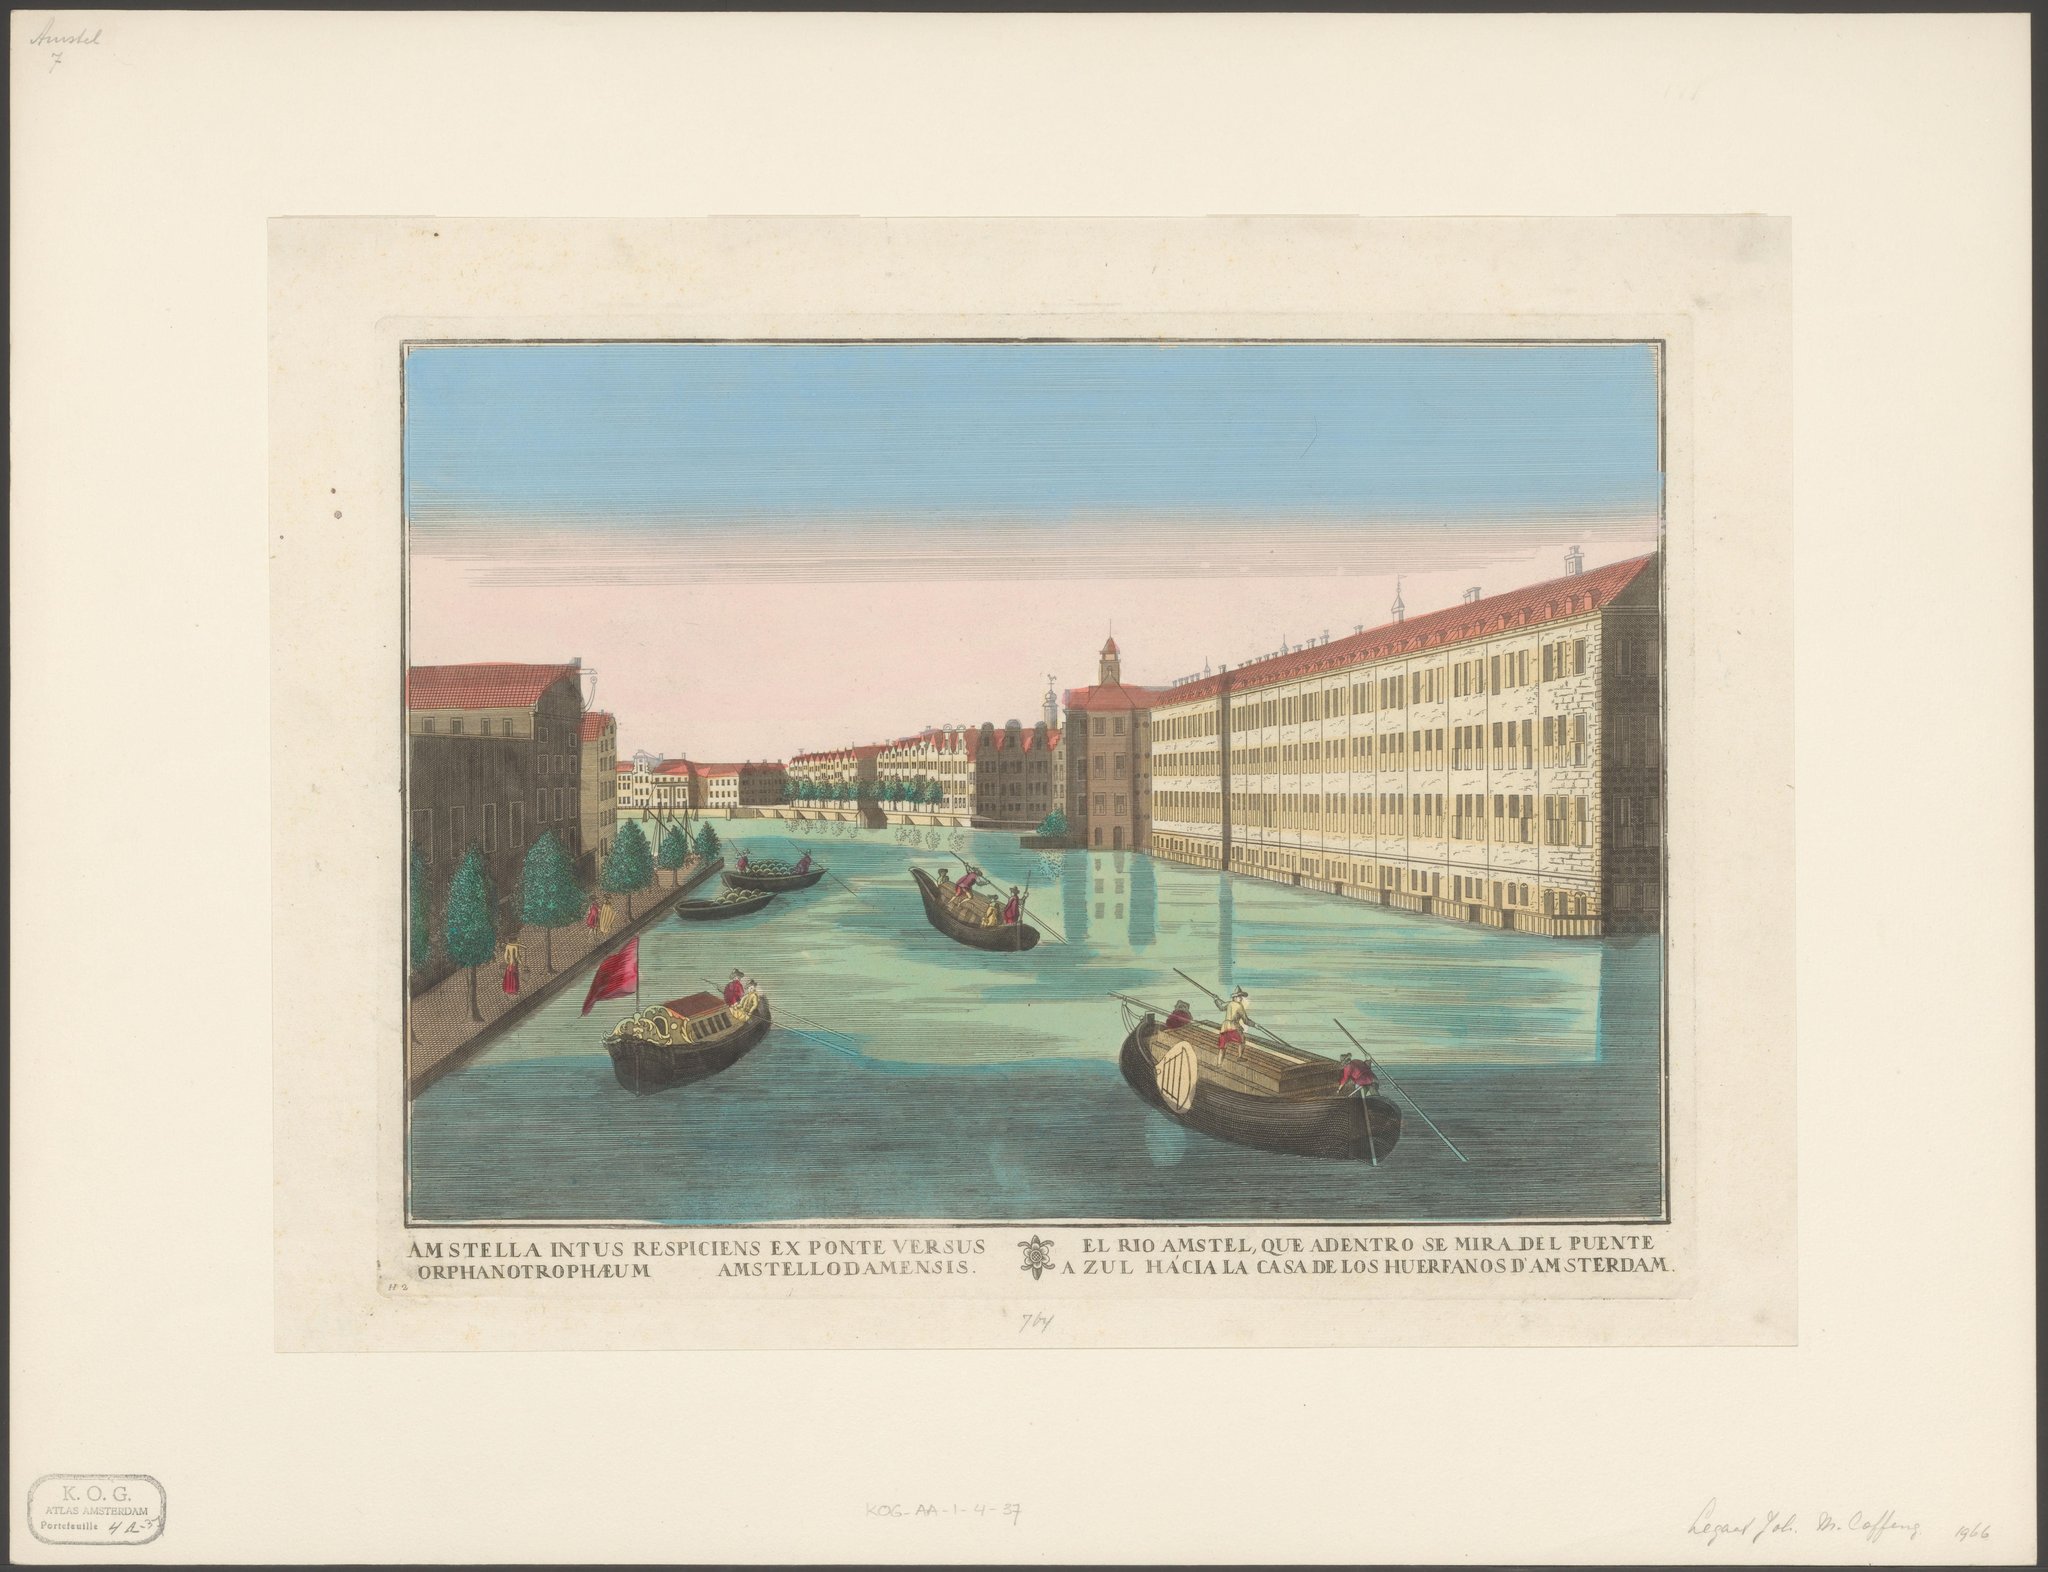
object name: print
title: Amstella intus respiciens ex ponte versus orphanotrophaeum amstellodamensis / El rio amstel, que adentro se mira del puente a zul hacia la casa de los huerfanos d'amsterdam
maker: Anonymous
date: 1700-1799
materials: paper, watercolor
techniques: engraving, etching, hand coloring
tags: city-view in general; 'veduta', canal, bridge in city across river, canal, etc., boat propelled by man or animal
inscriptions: collector's mark: ‘4A-37’ Lugt 1641b, inscription: ‘Legaat Joh. M. Coffeng. 1966’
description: Onderwerpsrubriek binnen de Atlas Amsterdam: Amstel van Doelensluis tot Blauwbrug.